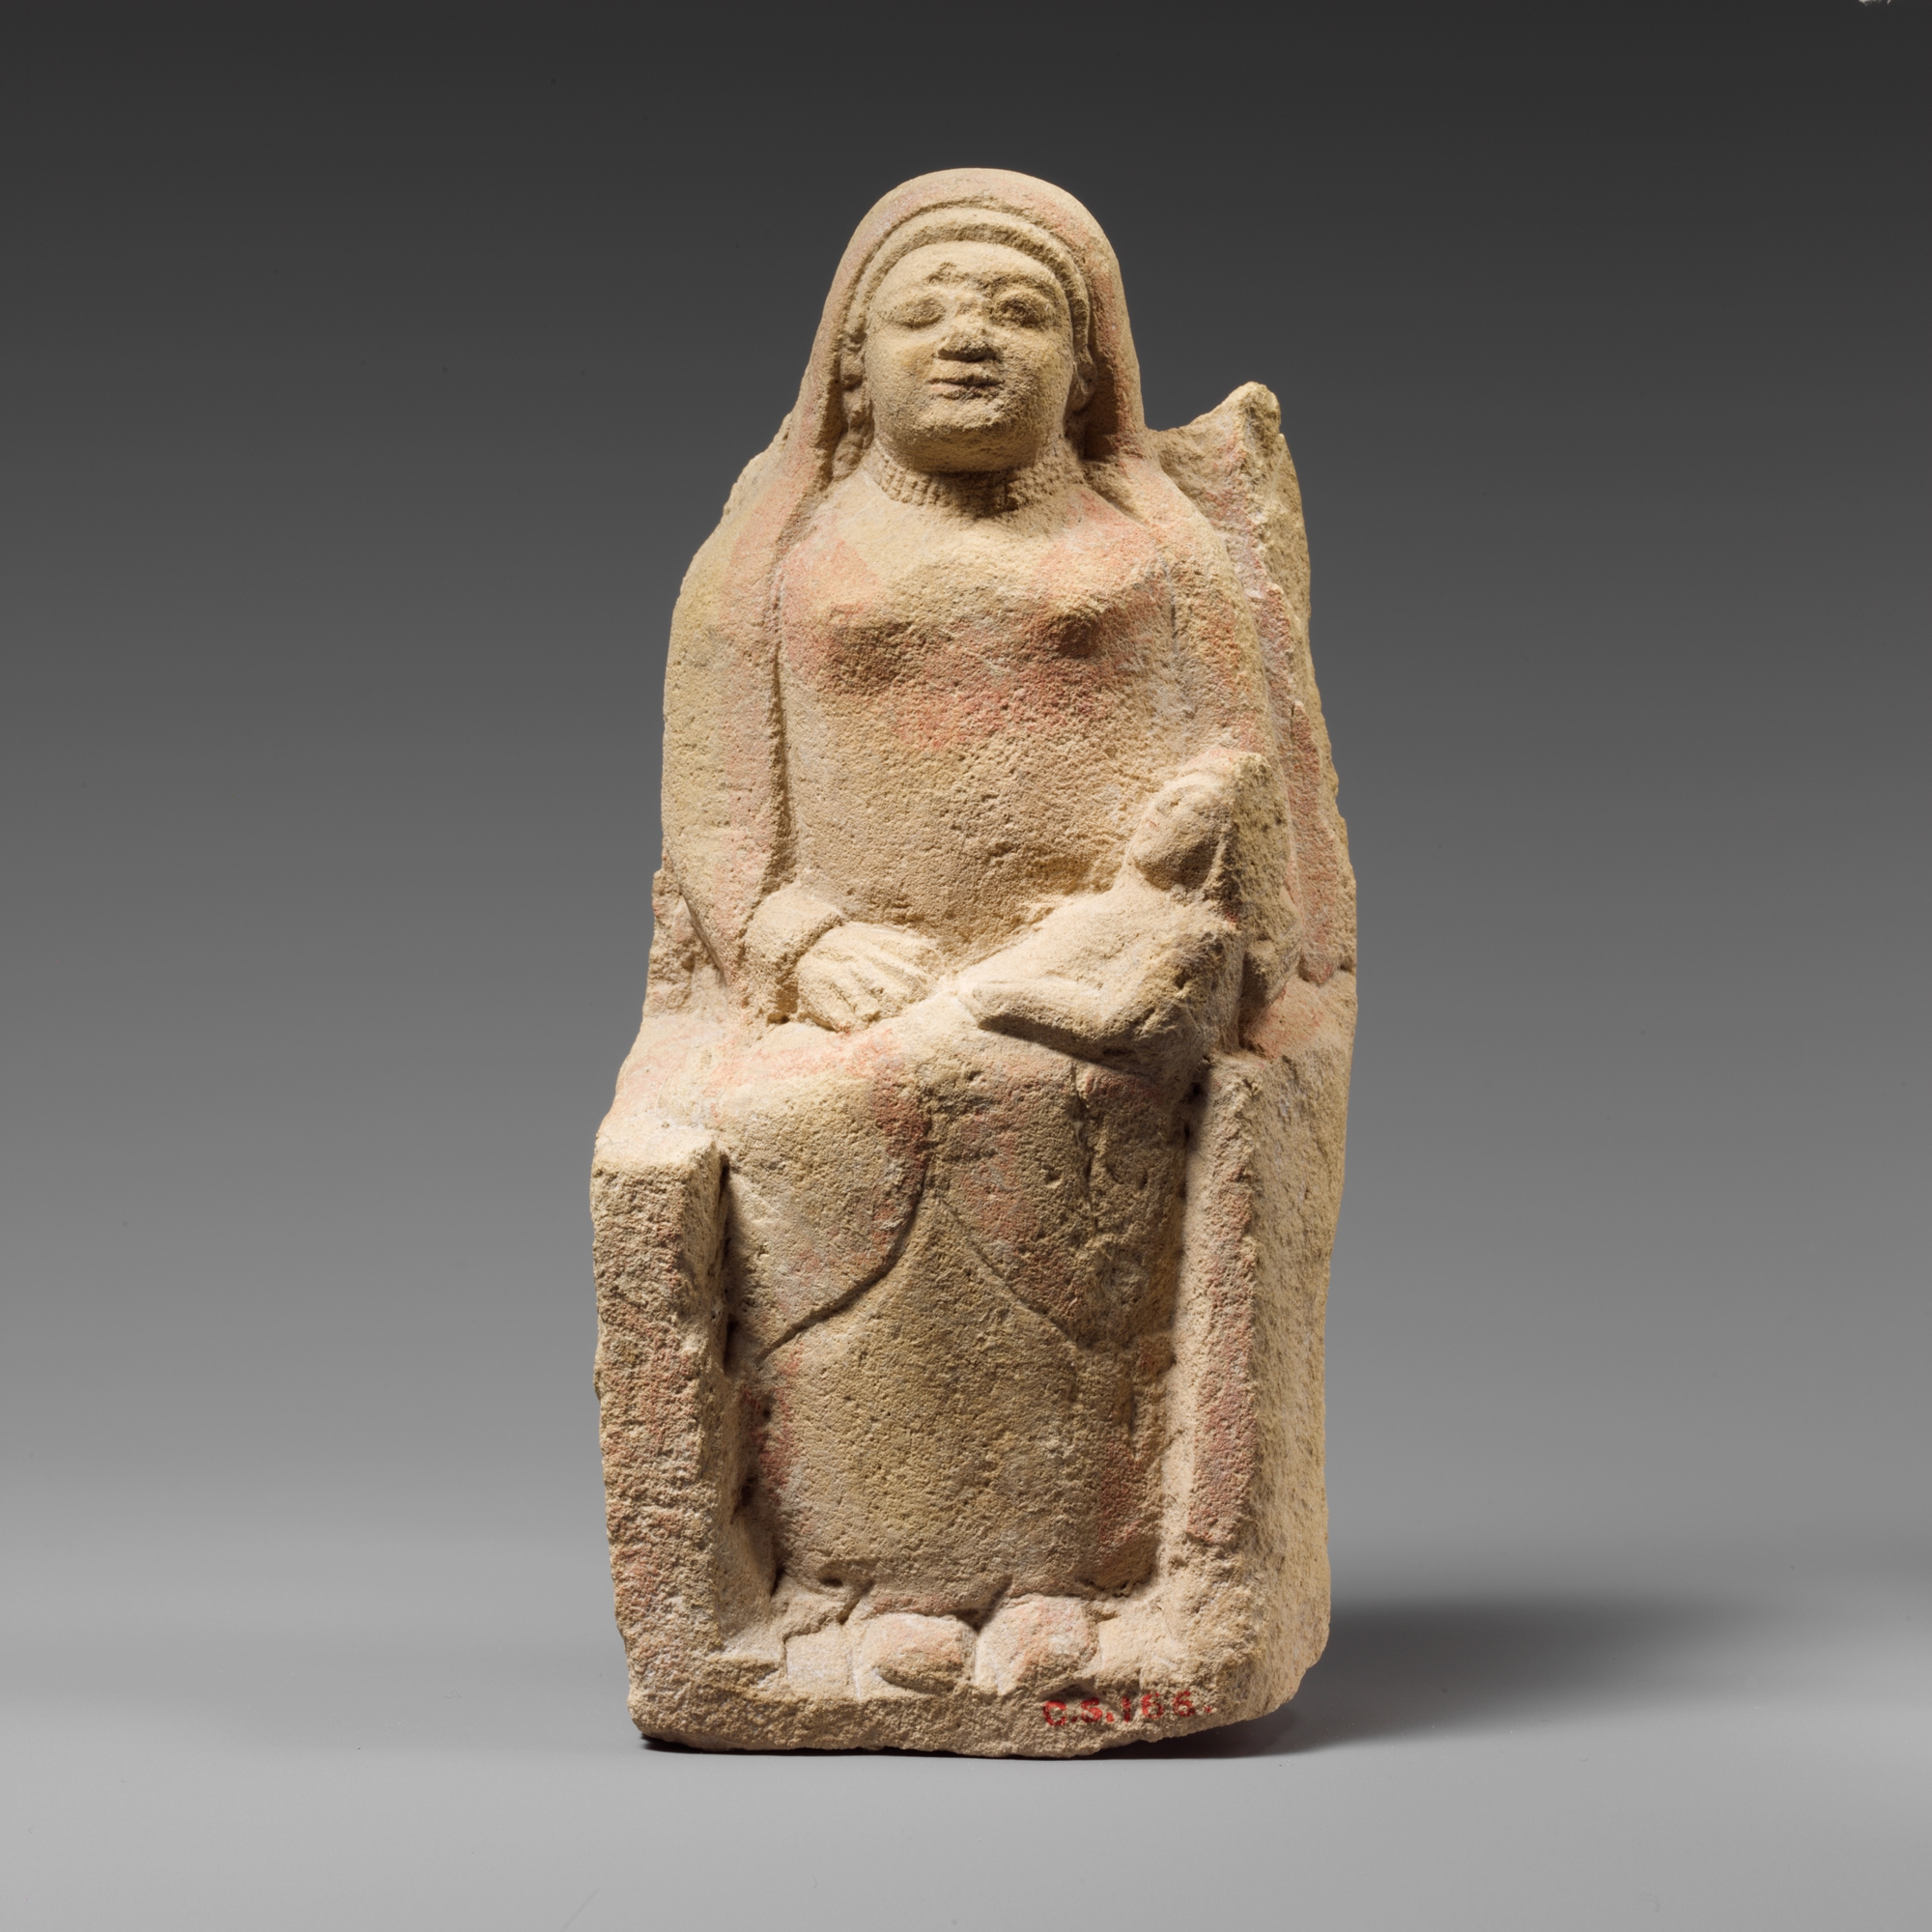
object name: statuette of a woman nursing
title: Seated limestone kourotrophos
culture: cypriot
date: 534-501 BCE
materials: limestone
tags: infants,women